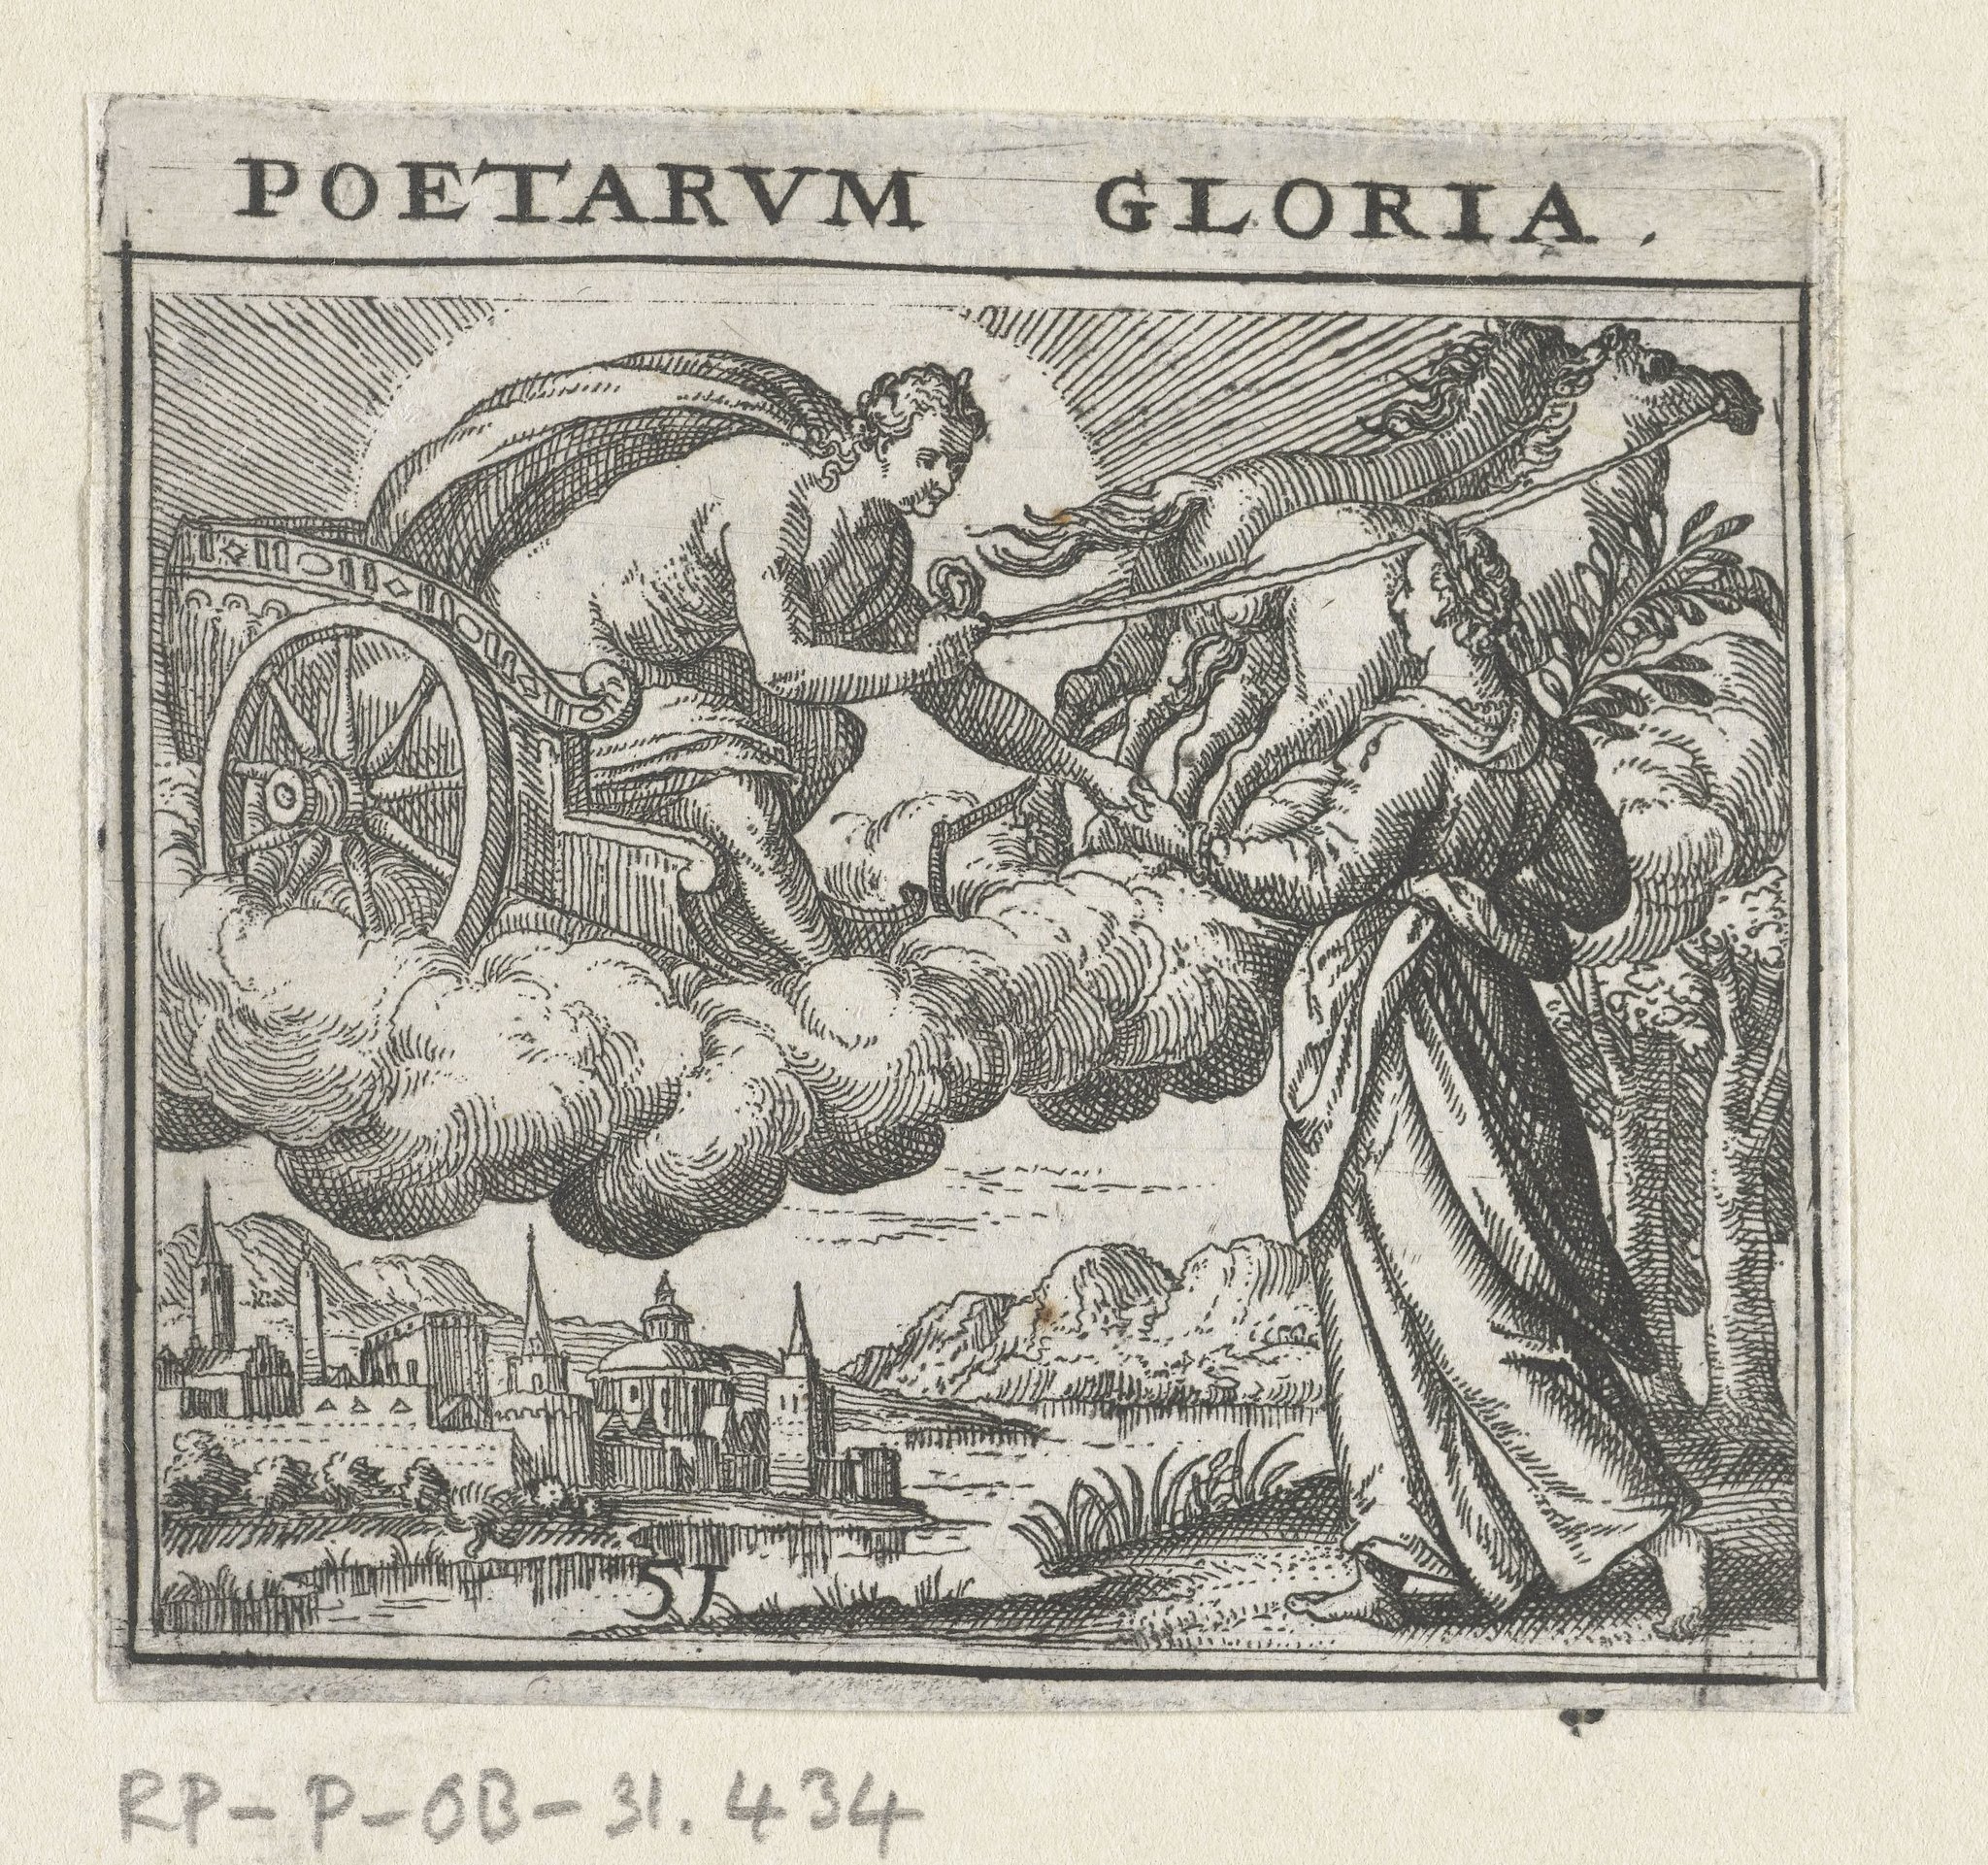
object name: book illustration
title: Denis Lebey de Batilly, Emblemata, 1596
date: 1596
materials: paper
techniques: engraving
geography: frankfurt am main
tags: the chariot of the sun, apollo as sun-god, i.e. sol (helius), titan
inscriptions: collector's mark: Lugt 240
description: Apollo zit in de zonnewagen die getrokken wordt door twee paarden. Hij stopt de wagen om te praten met een vrouw die een palmtak in haar hand houdt.